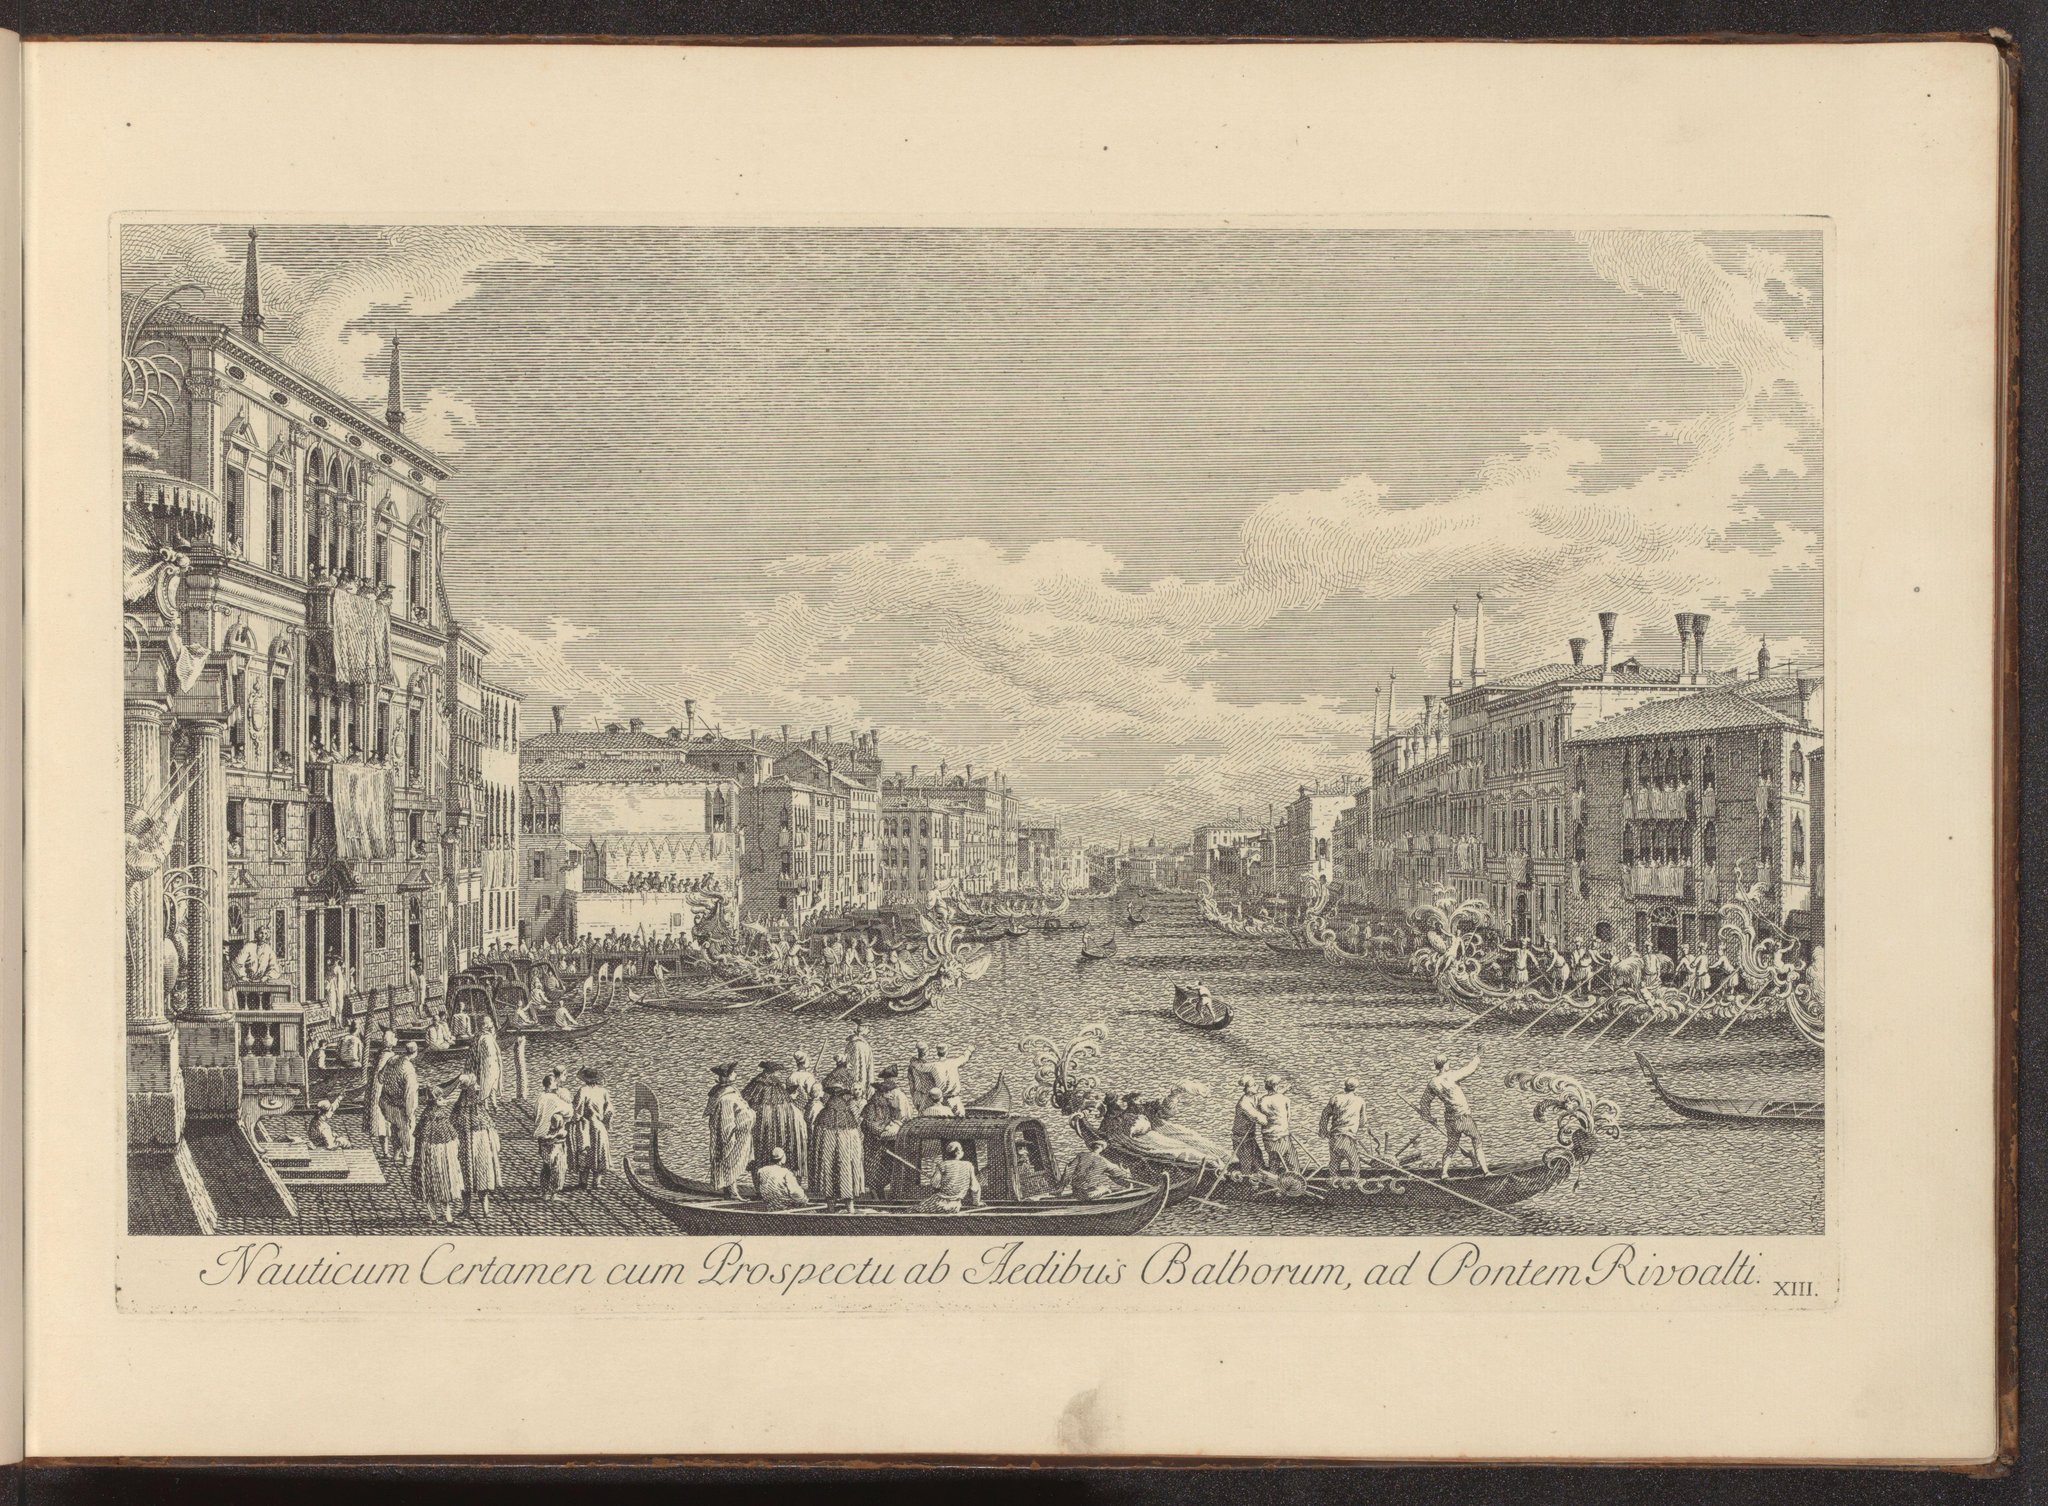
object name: album leaf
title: Nauticum Certamen cum Prospectu ab Aedibus Balborum, ad Pontem Rivoalti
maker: antonio visentini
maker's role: draughtsman, print maker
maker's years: 1688-1782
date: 1742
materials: paper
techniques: etching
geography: venice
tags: city-view, and landscape with man-made constructions, canal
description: Gezicht op het Canal Grande te Venetië waar de historische roeiwedstrijd: de Regata plaatsvindt. Links Palazzo Balbi. De prent maakt deel uit van een album.